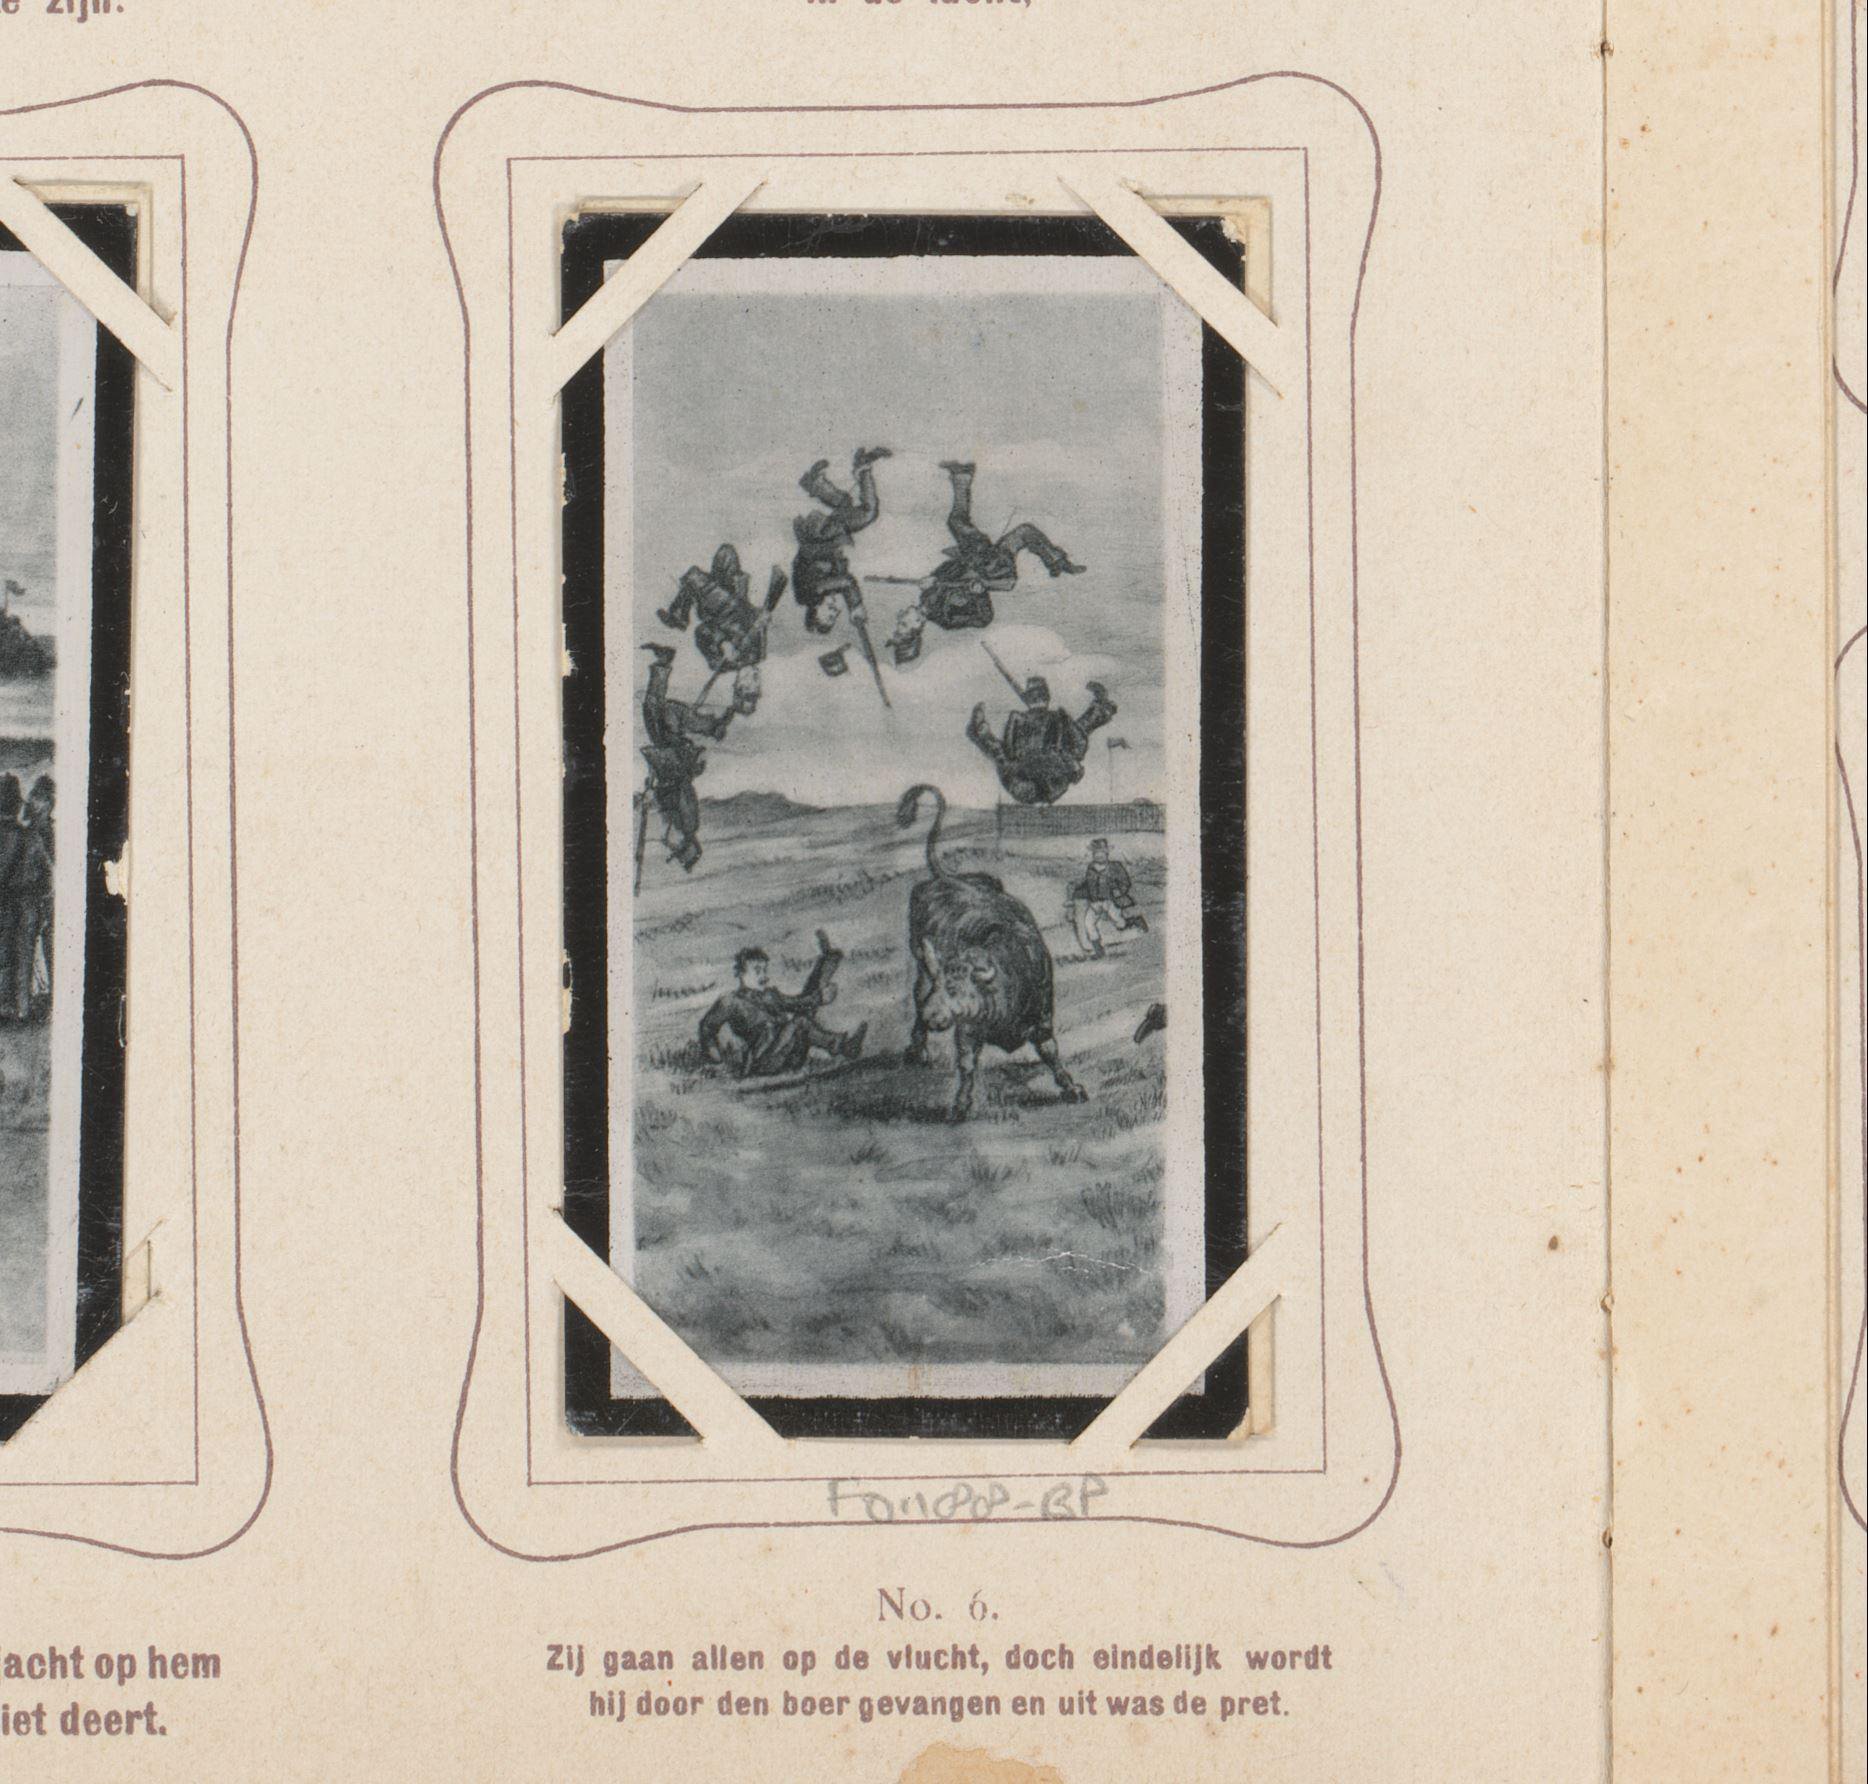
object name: reproduction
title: Reproductie van een tekening van een prijswinnende os die soldaten in de lucht werpt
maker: Anonymous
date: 1906-1907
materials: paper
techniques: photograph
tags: prize-ox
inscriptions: inscription: ‘No. 6./ Zij gaan allen op de vlucht, doch eindelijk wordt hij door een boer gevangen en uit was de pret.’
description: Deze prent maakt deel uit van een album.